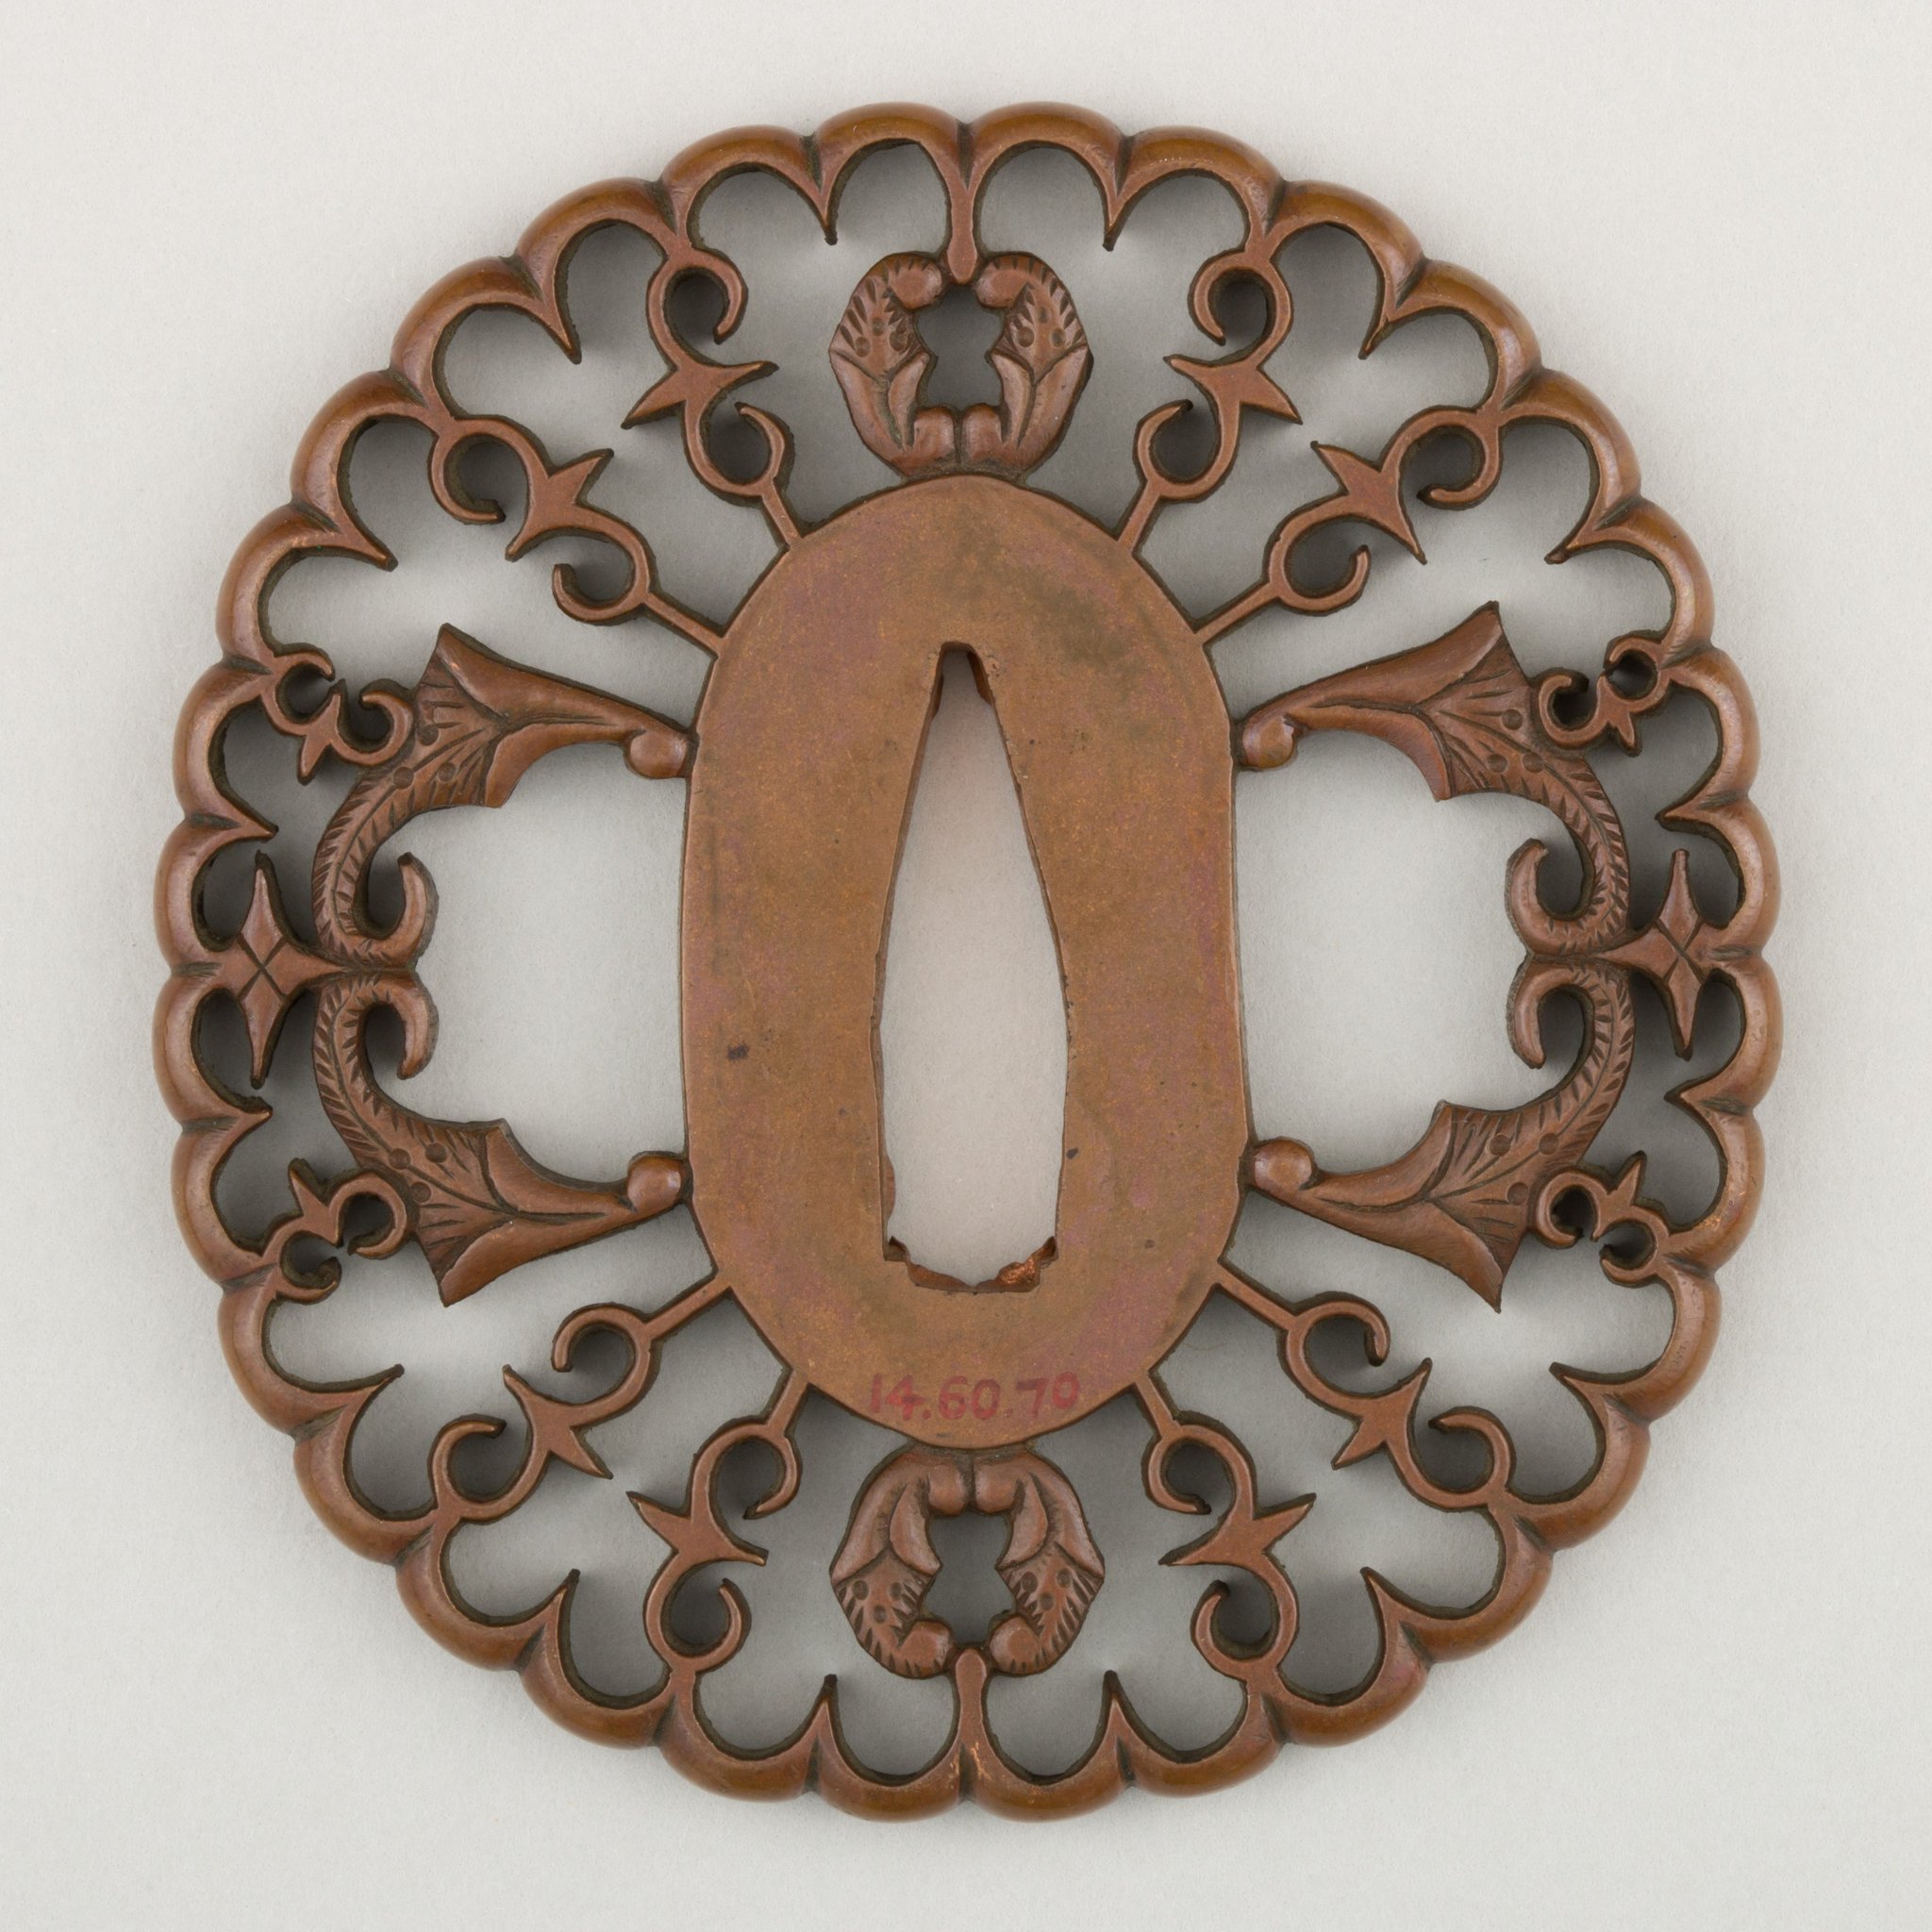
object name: sword guard tsuba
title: Sword Guard (Tsuba)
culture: japanese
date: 1701-1800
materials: copper, copper alloy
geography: japan